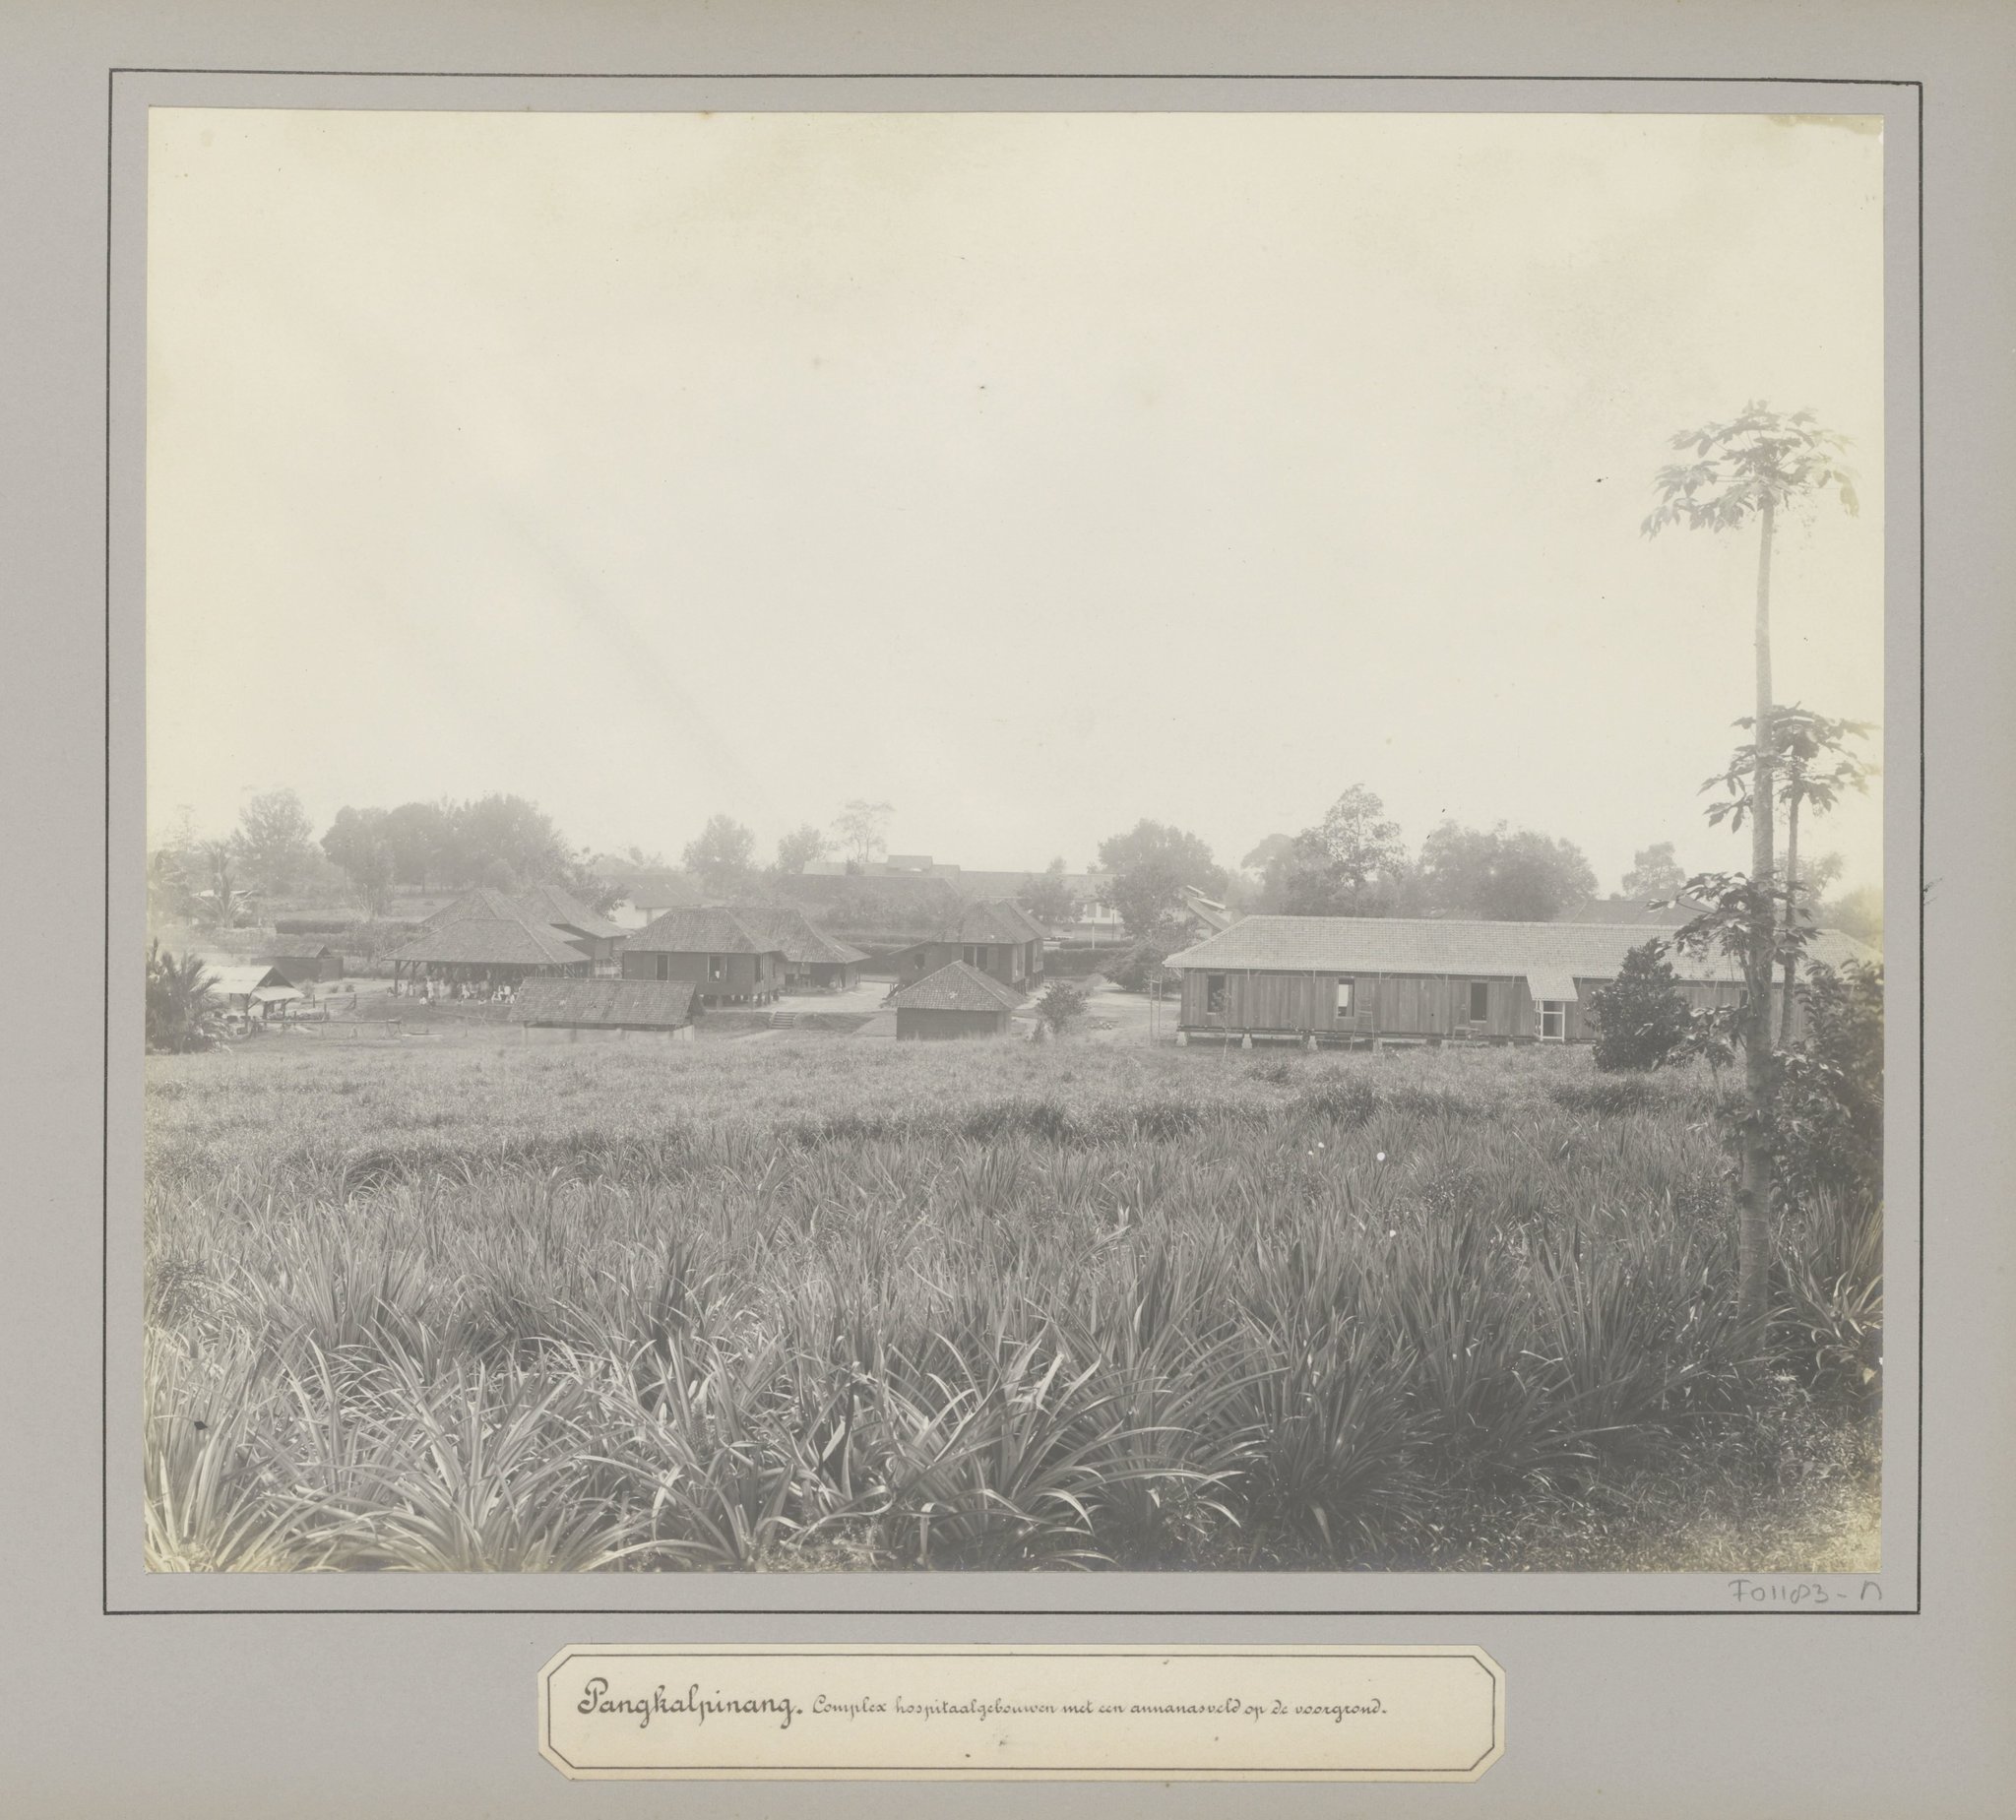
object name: photograph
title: Pangkalpinang. Complex hospitaalgebouwen met een ananasveld op de voorgrond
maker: Anonymous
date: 1900-1920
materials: photographic support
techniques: gelatin silver print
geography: pangkalpinang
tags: field filled with a crop, mining, minerals and metals: tin, hospital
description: Onderdeel van Fotoalbum over de tinwinning op Bangka.